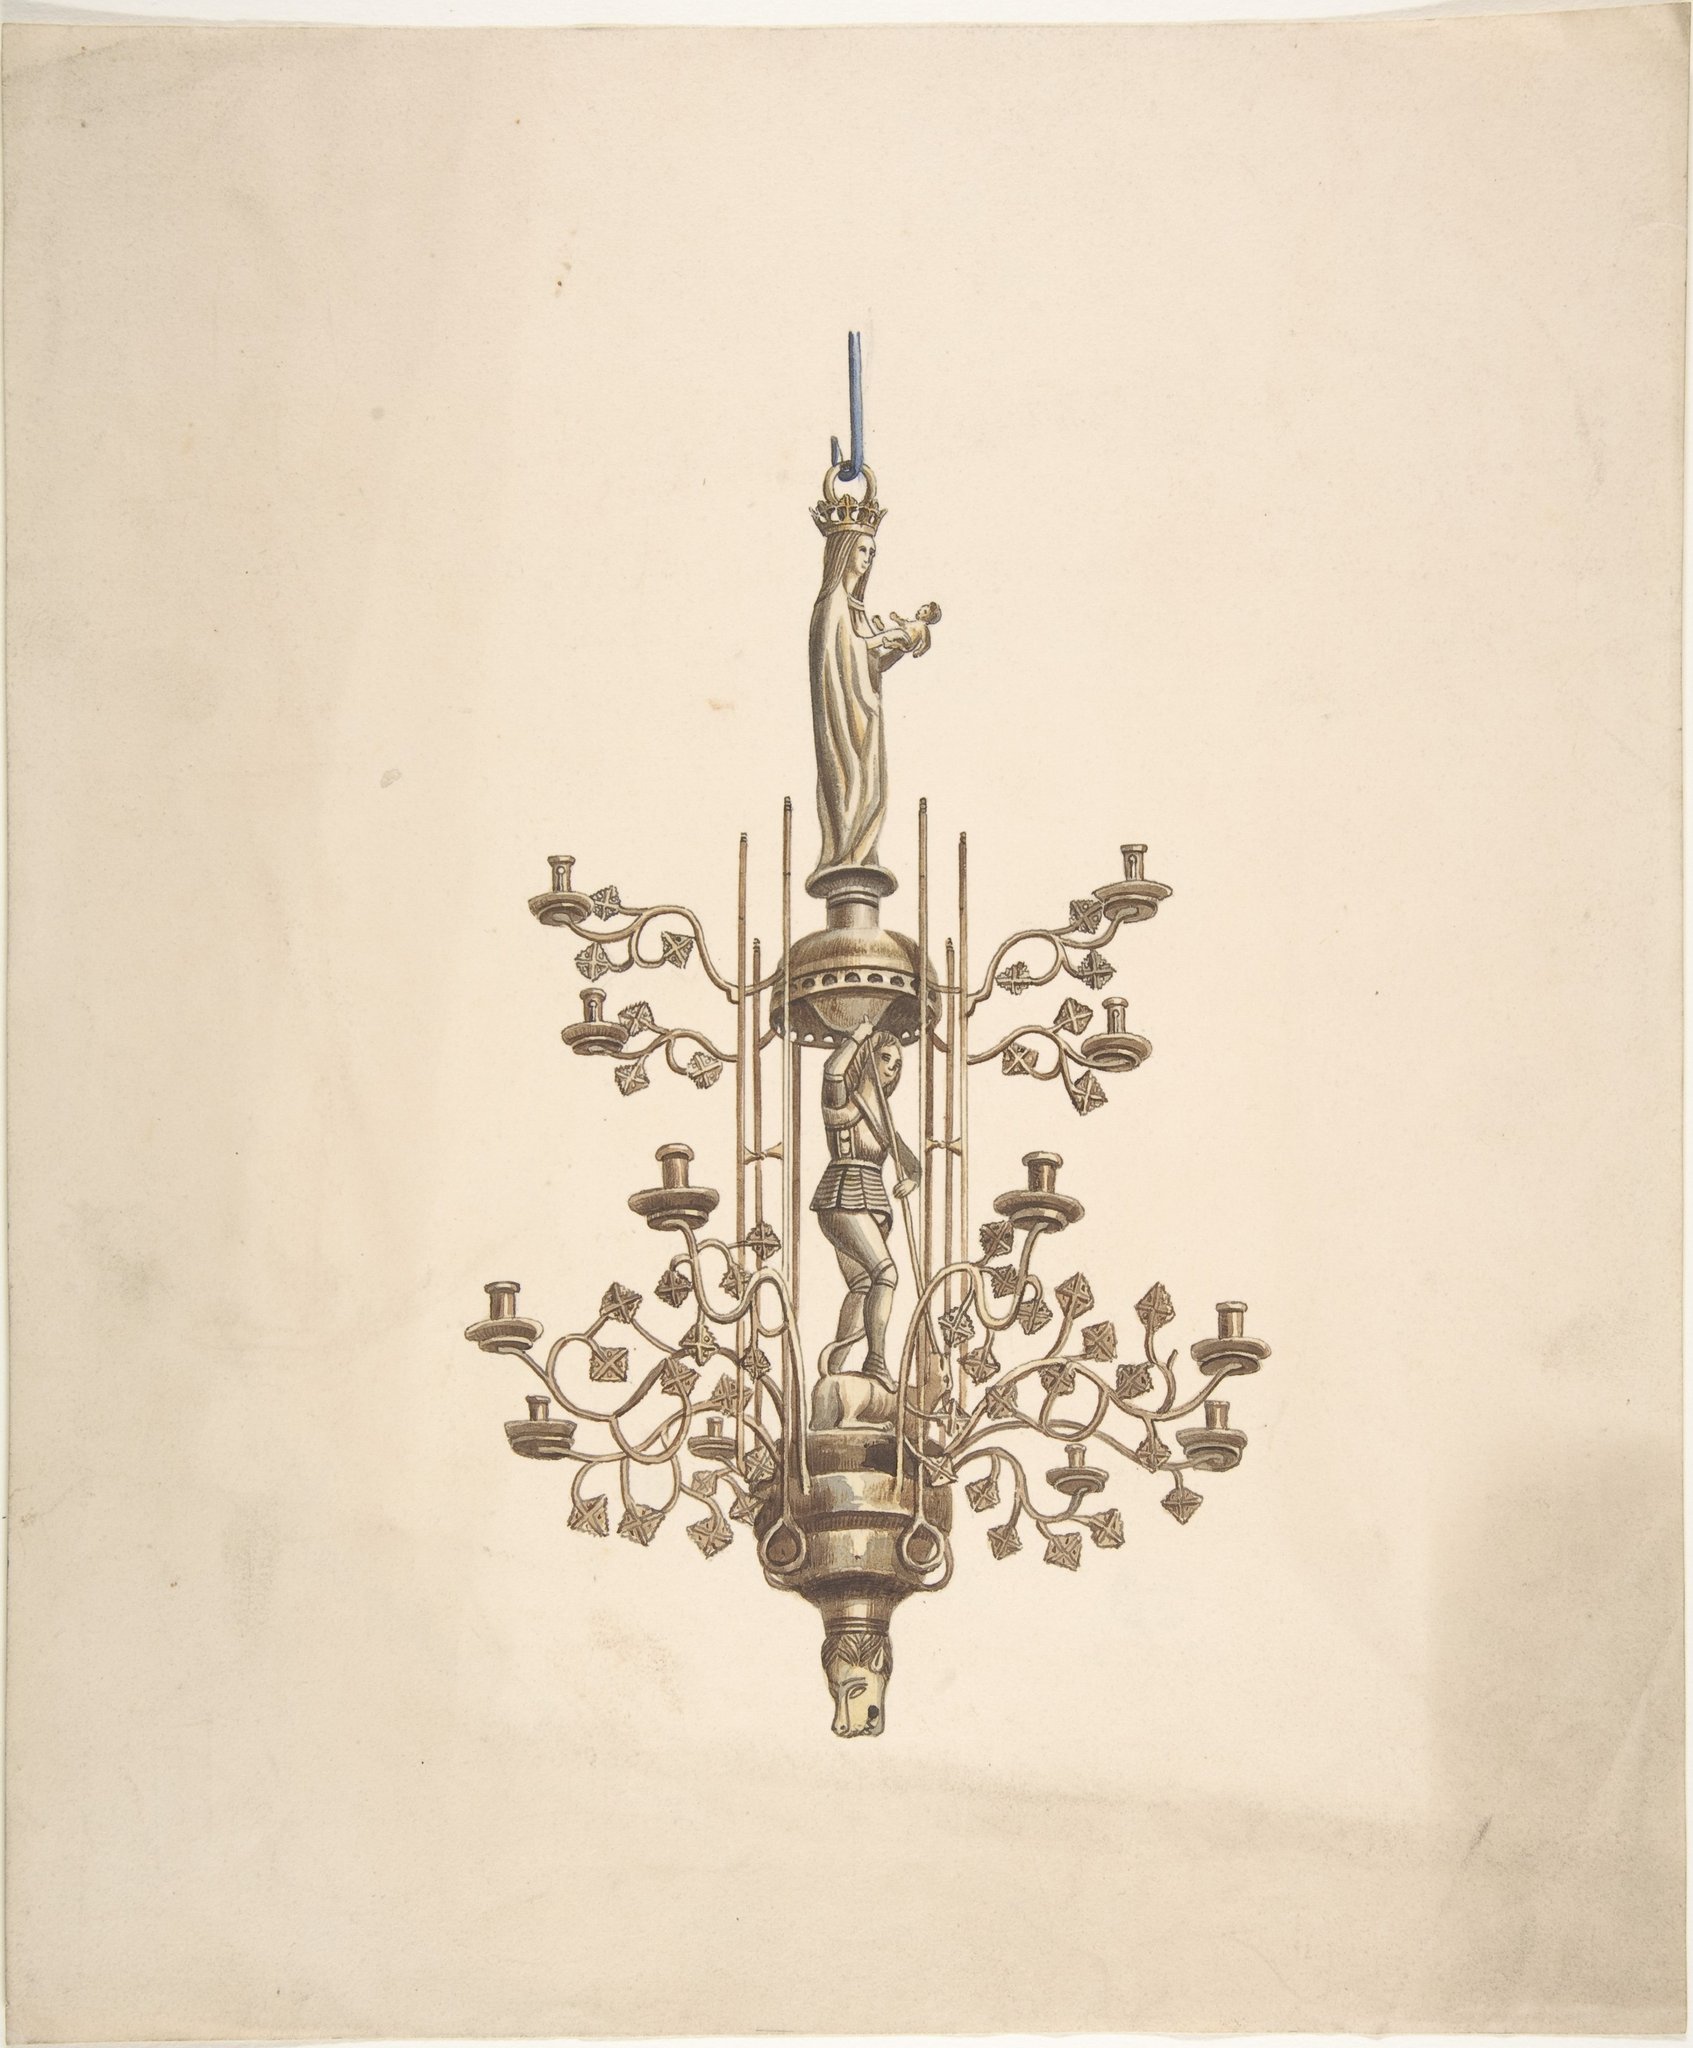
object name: drawing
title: Design for a candelabrum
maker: anonymous, british, 19th century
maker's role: artist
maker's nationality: british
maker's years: 1800-1900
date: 1801-1900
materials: ink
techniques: brush, pen, wash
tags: candelabra